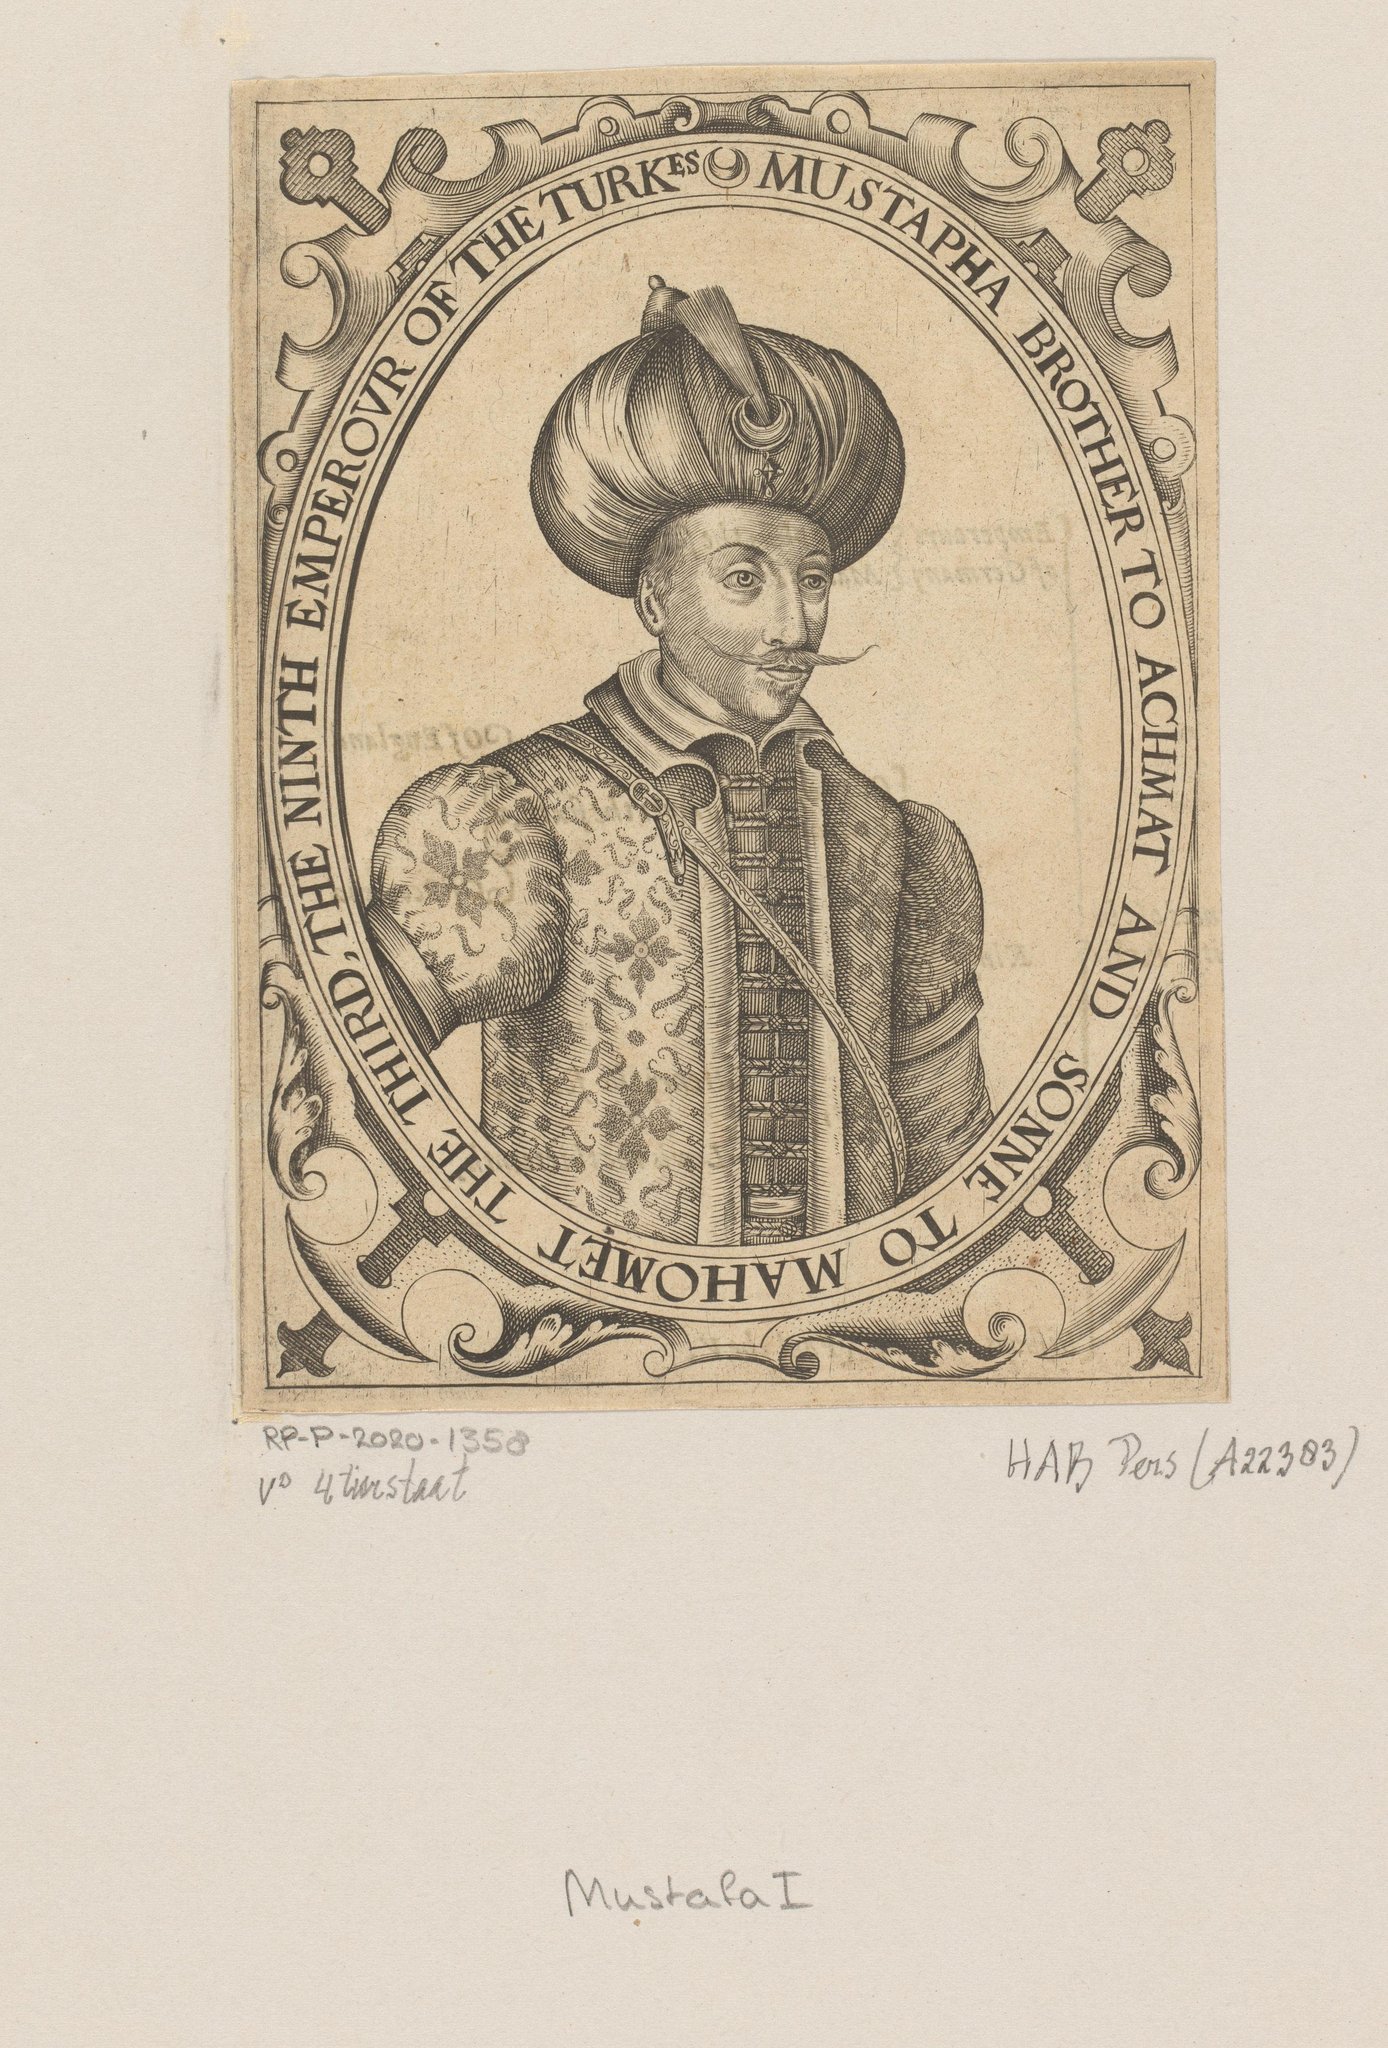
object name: print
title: Portret van Mustafa I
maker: Anonymous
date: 1595-1622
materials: paper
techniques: engraving, letterpress printing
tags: historical persons